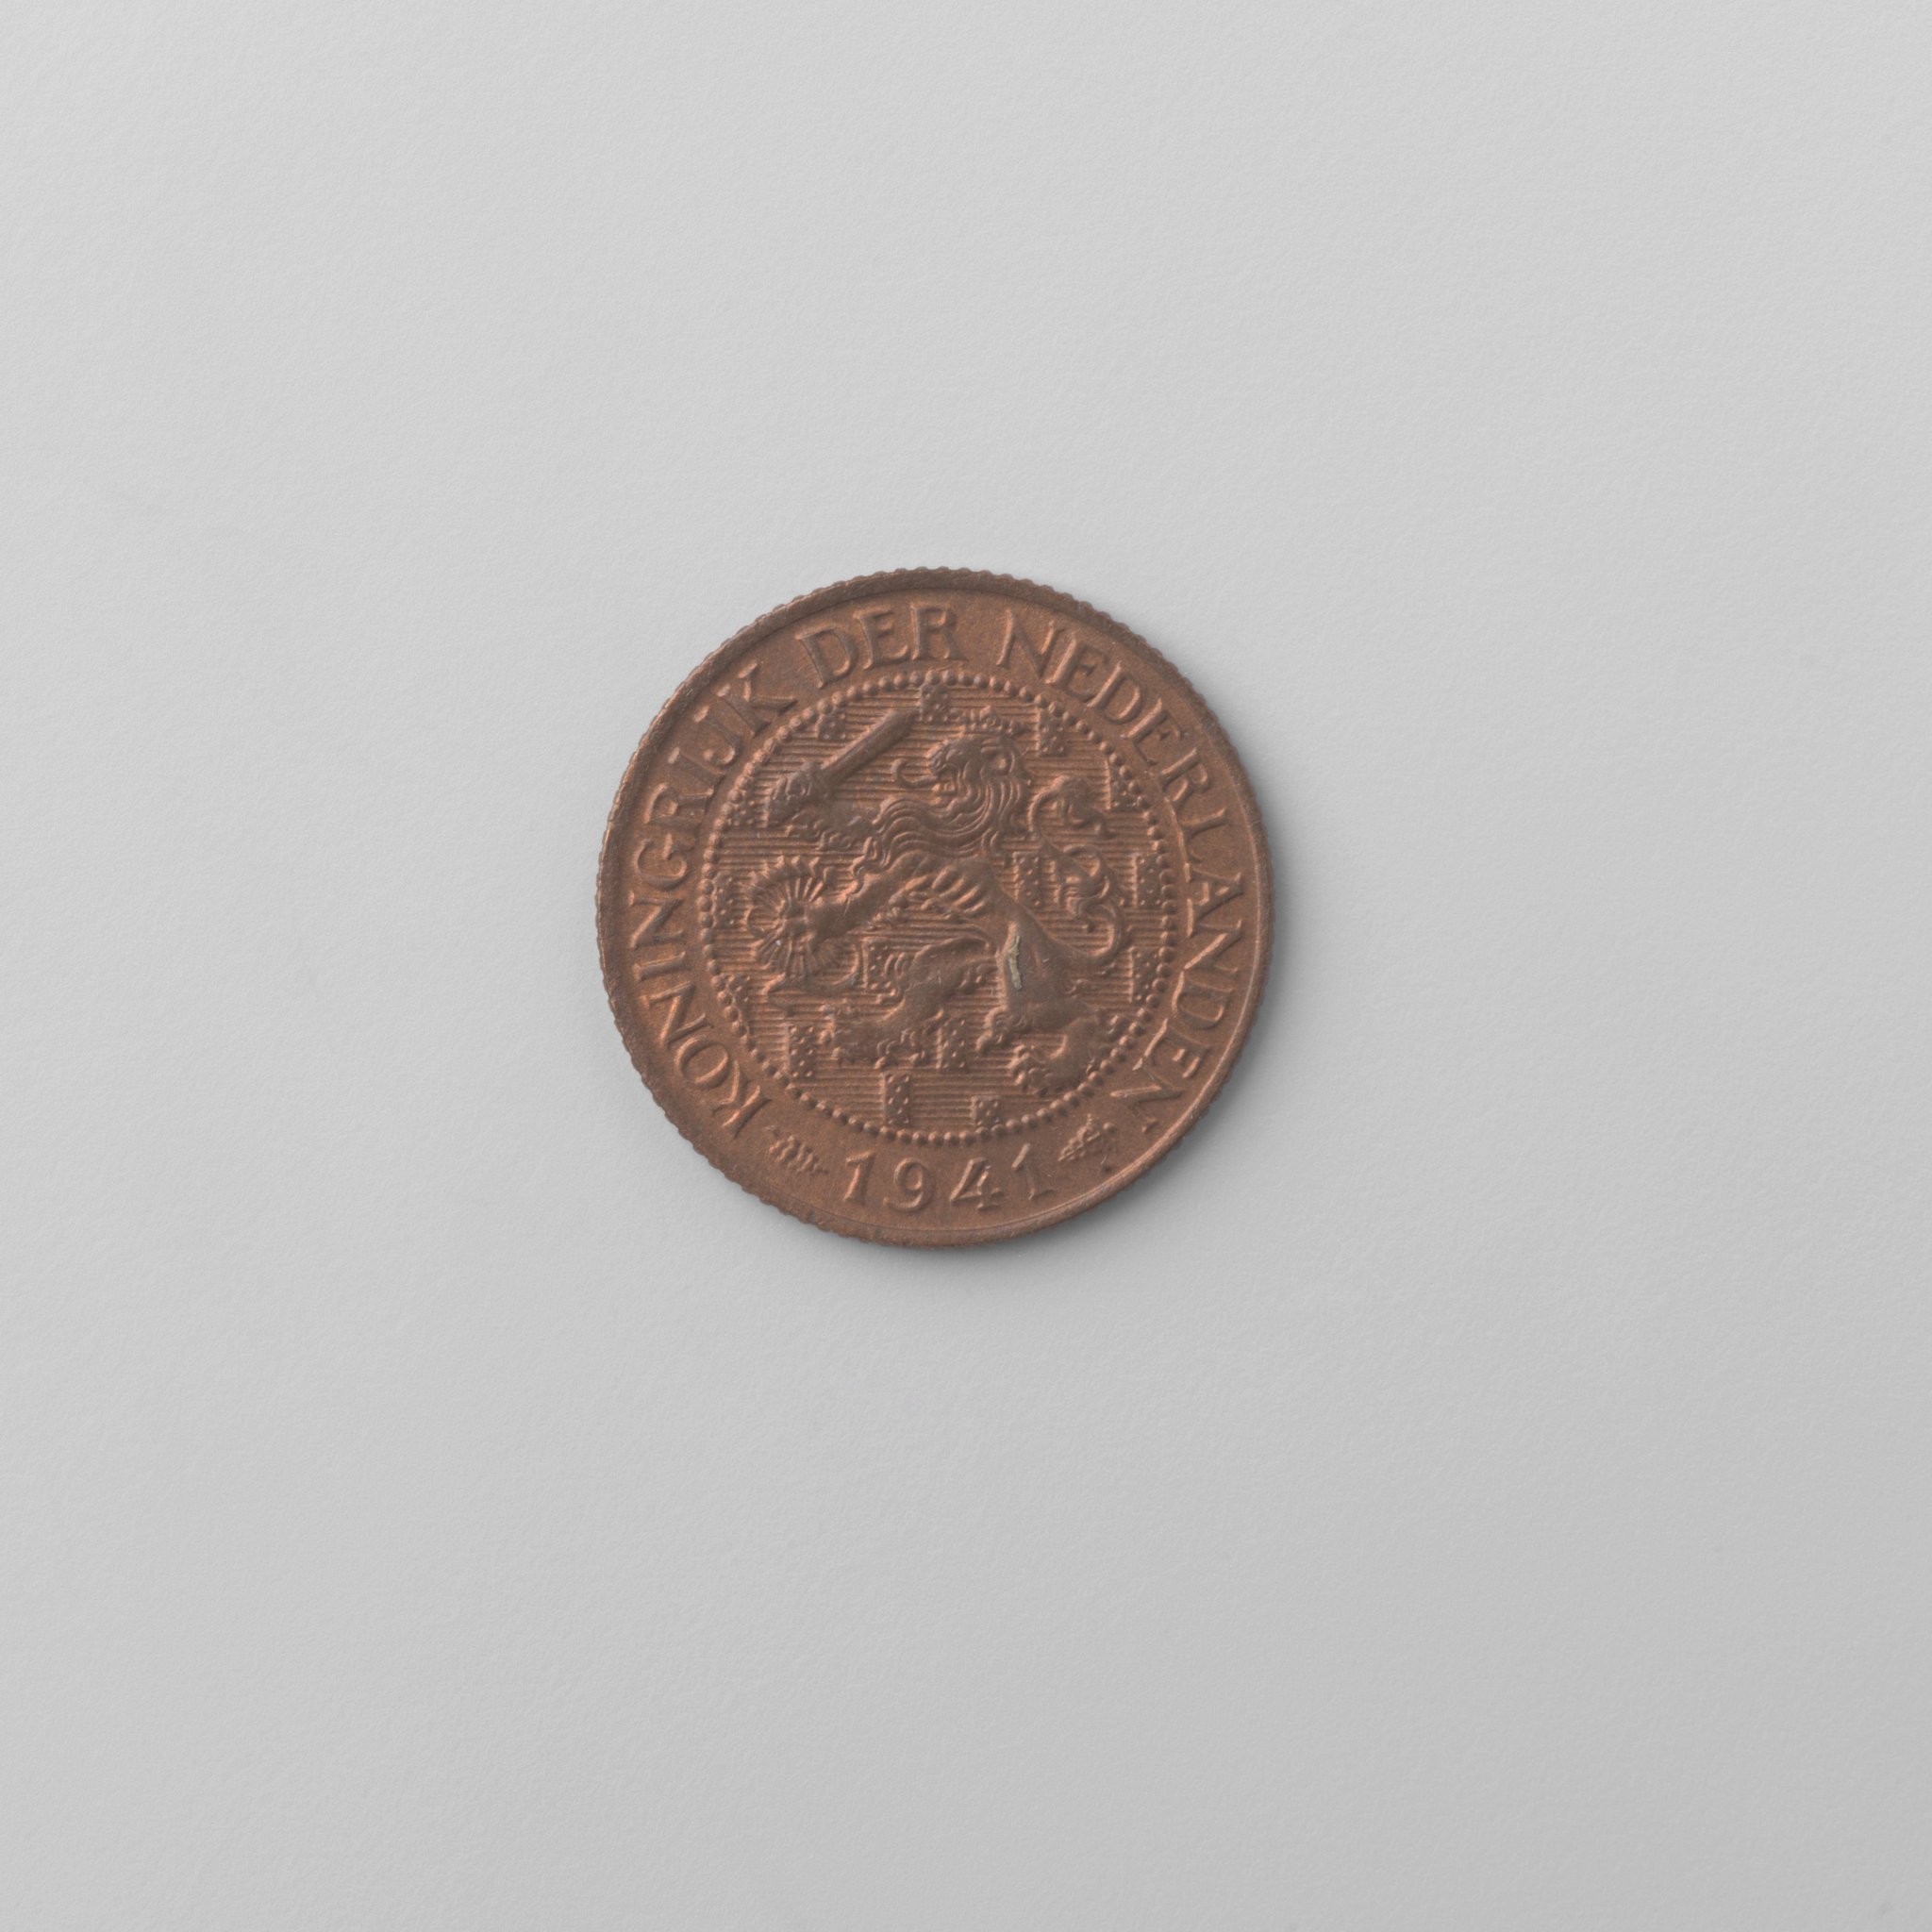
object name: coin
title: Nederland, cent,1941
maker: wilhelmina of the netherlands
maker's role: print maker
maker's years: 1880-1962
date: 1941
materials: bronze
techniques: striking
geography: utrecht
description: Bronzen munt. Voorzijde: in een veld rijkswapen. Jaartal onderaan in omschrift. Keerzijde: binnen twee samengebonden oranjetakken waarde-aanduiding 1 cent. Kartelrand.